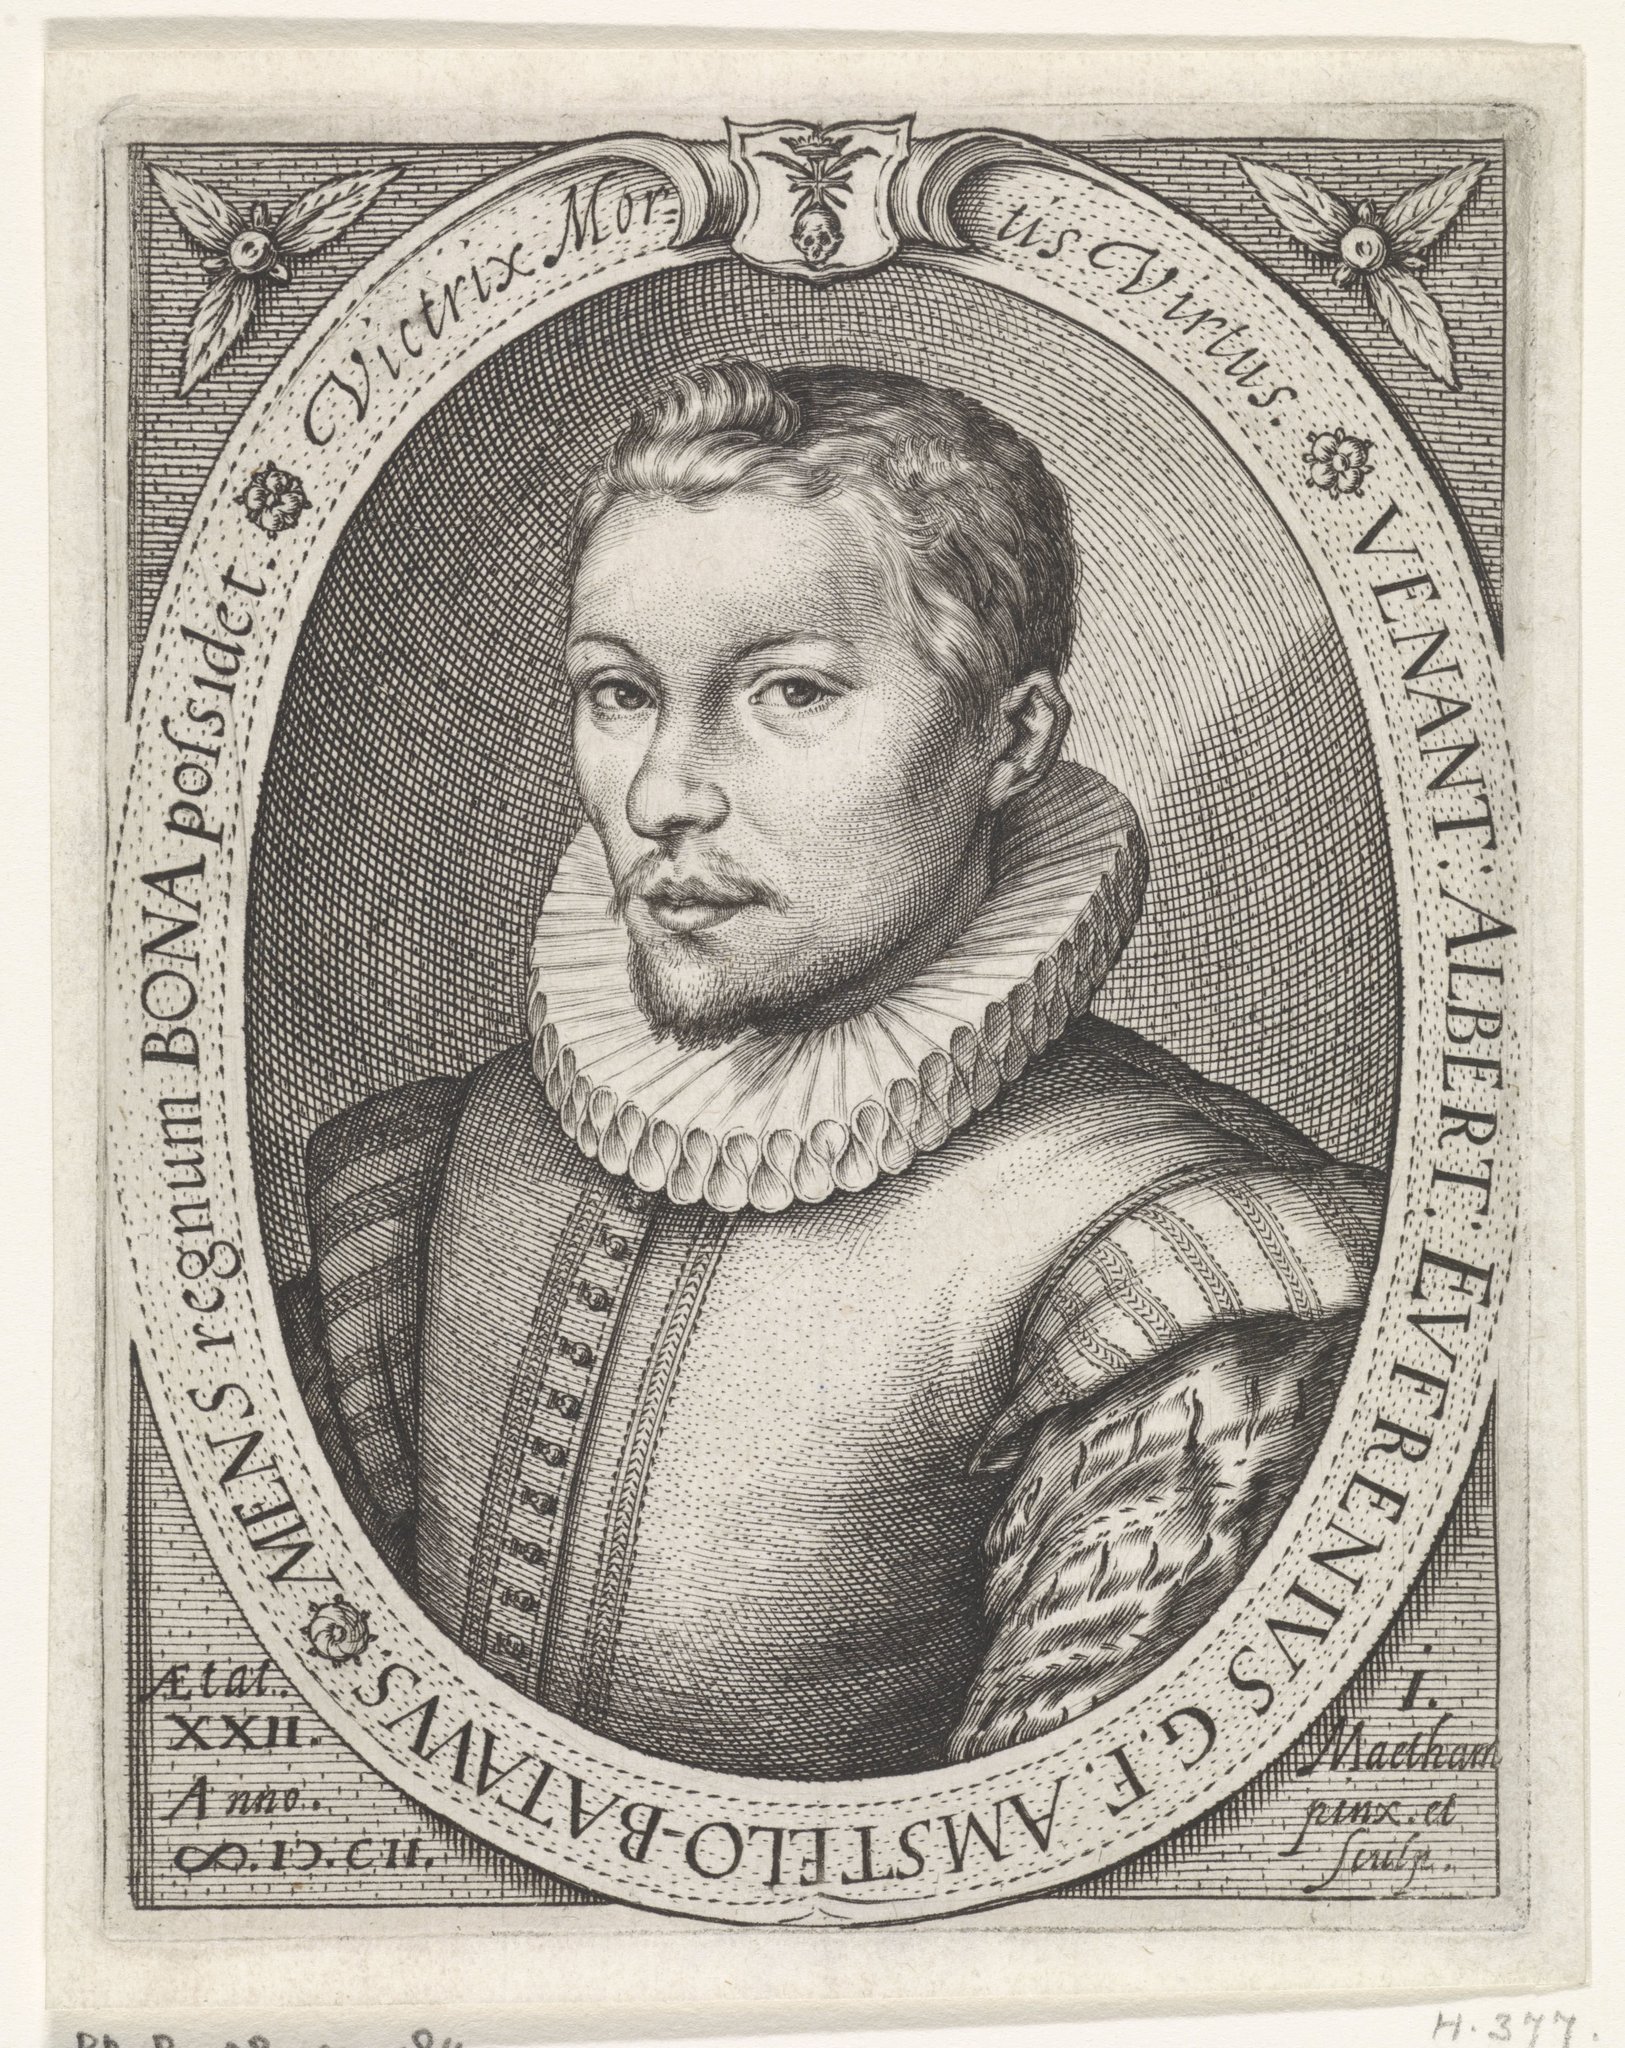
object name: print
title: Rest on the Flight into Egypt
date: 1589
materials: paper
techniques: engraving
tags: rest on the flight into egypt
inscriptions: collector's mark: Lugt 240